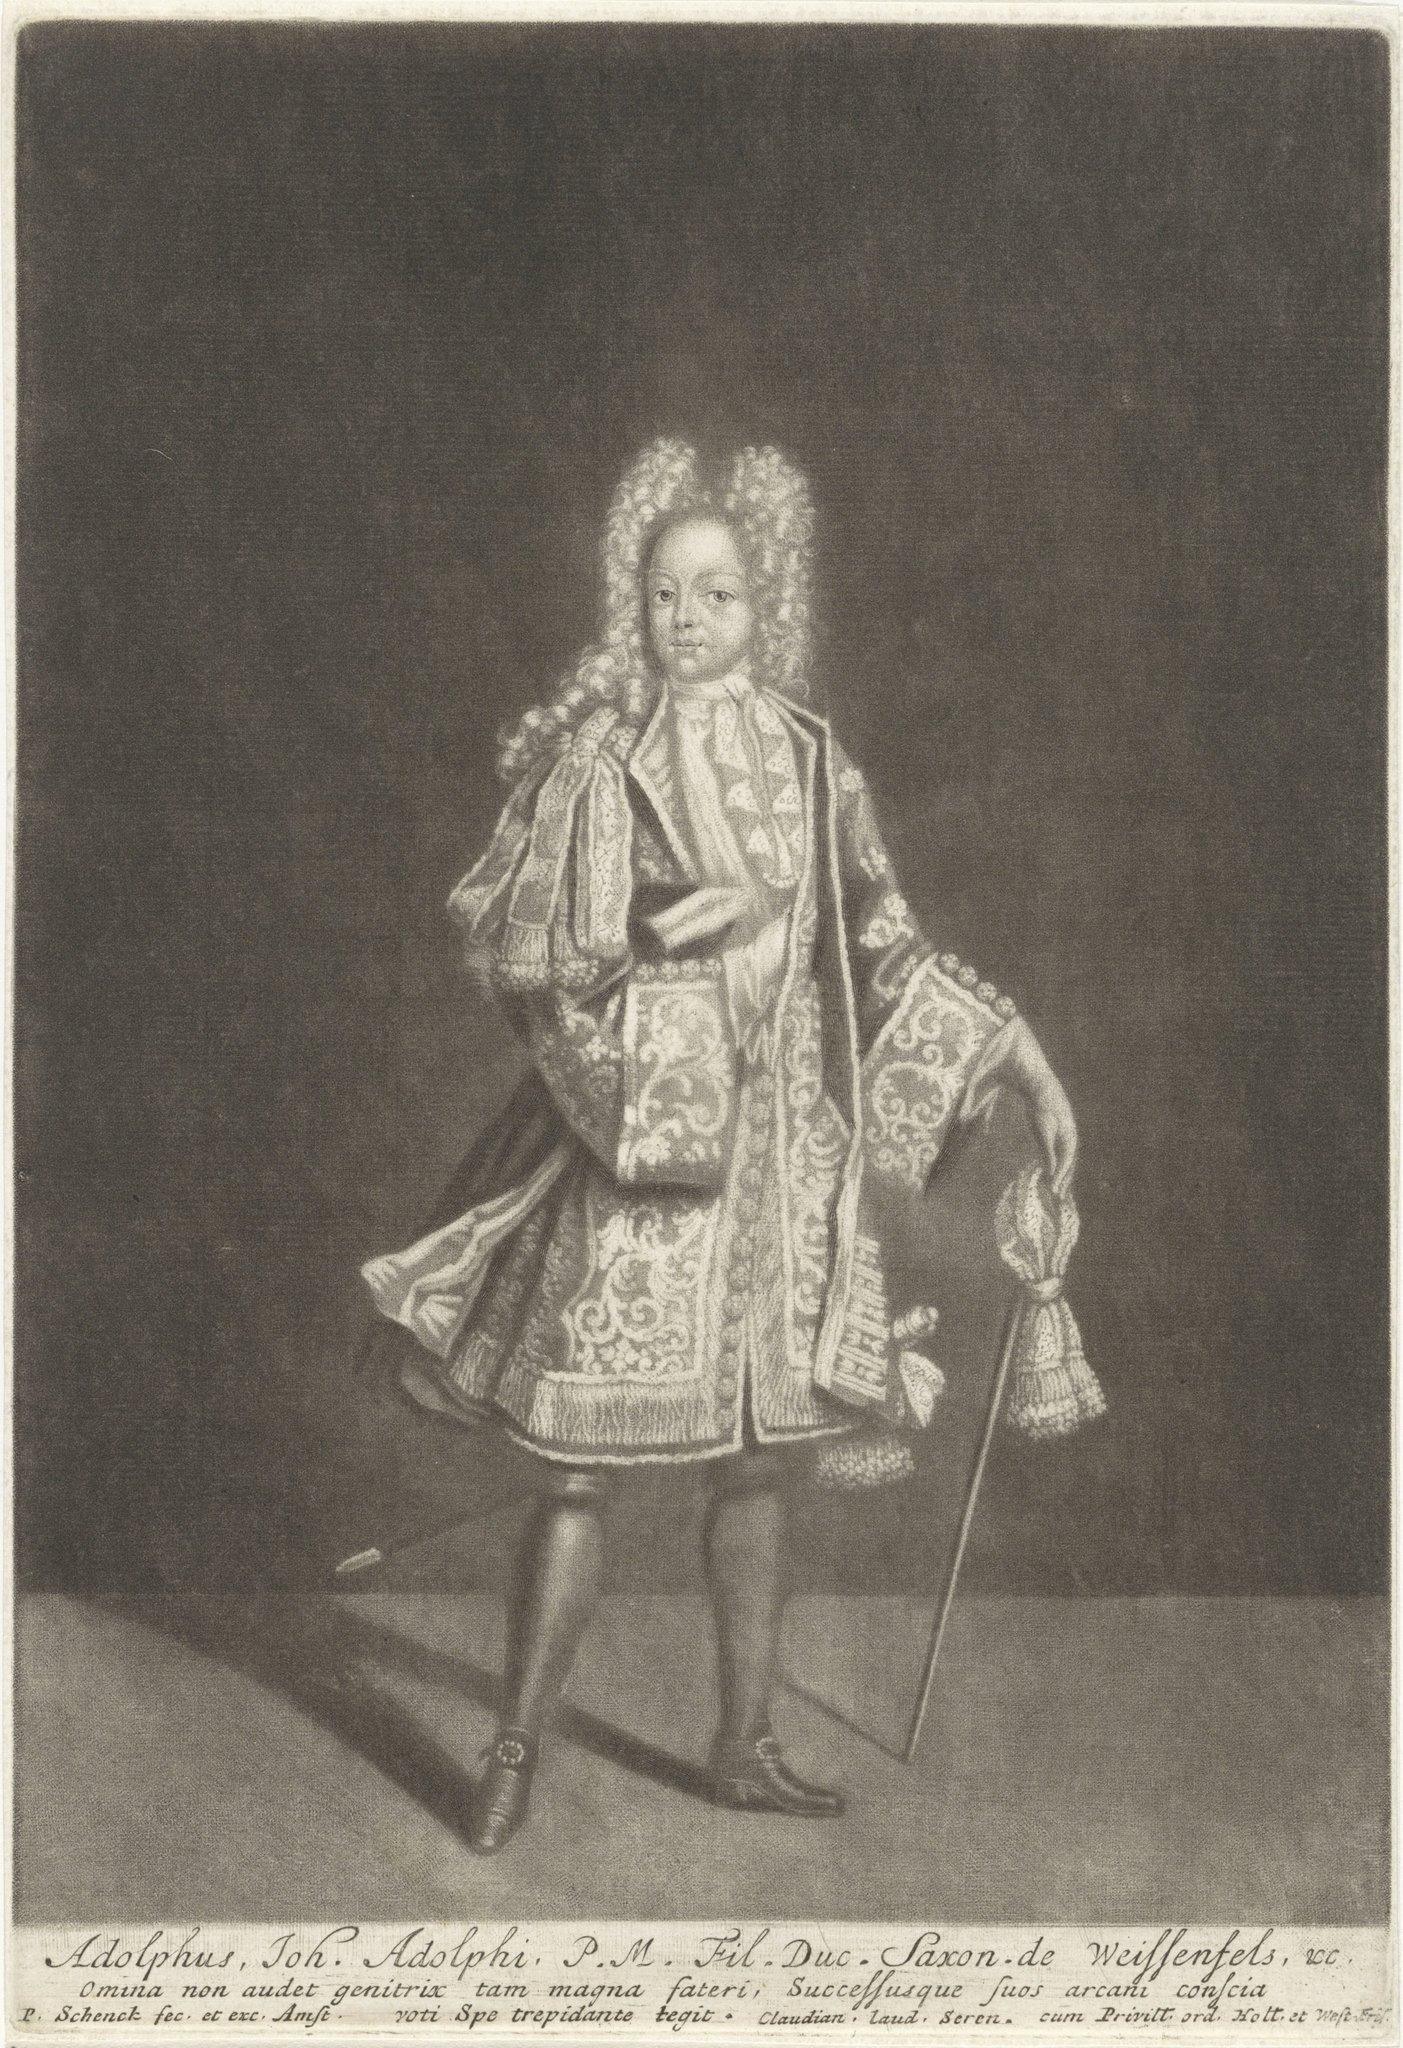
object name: print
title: Portret van Johann Adolph II van Saksen-Weissenfels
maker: pieter schenk (i)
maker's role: print maker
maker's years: 1660-1711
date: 1670-1713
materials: paper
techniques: engraving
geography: amsterdam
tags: wig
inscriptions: collector's mark: Lugt 2165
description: Johann Adolph II, hertog van Saksen-Weissenfels, op jonge leeftijd. Hij draagt een pruik en heeft een stok in de hand.